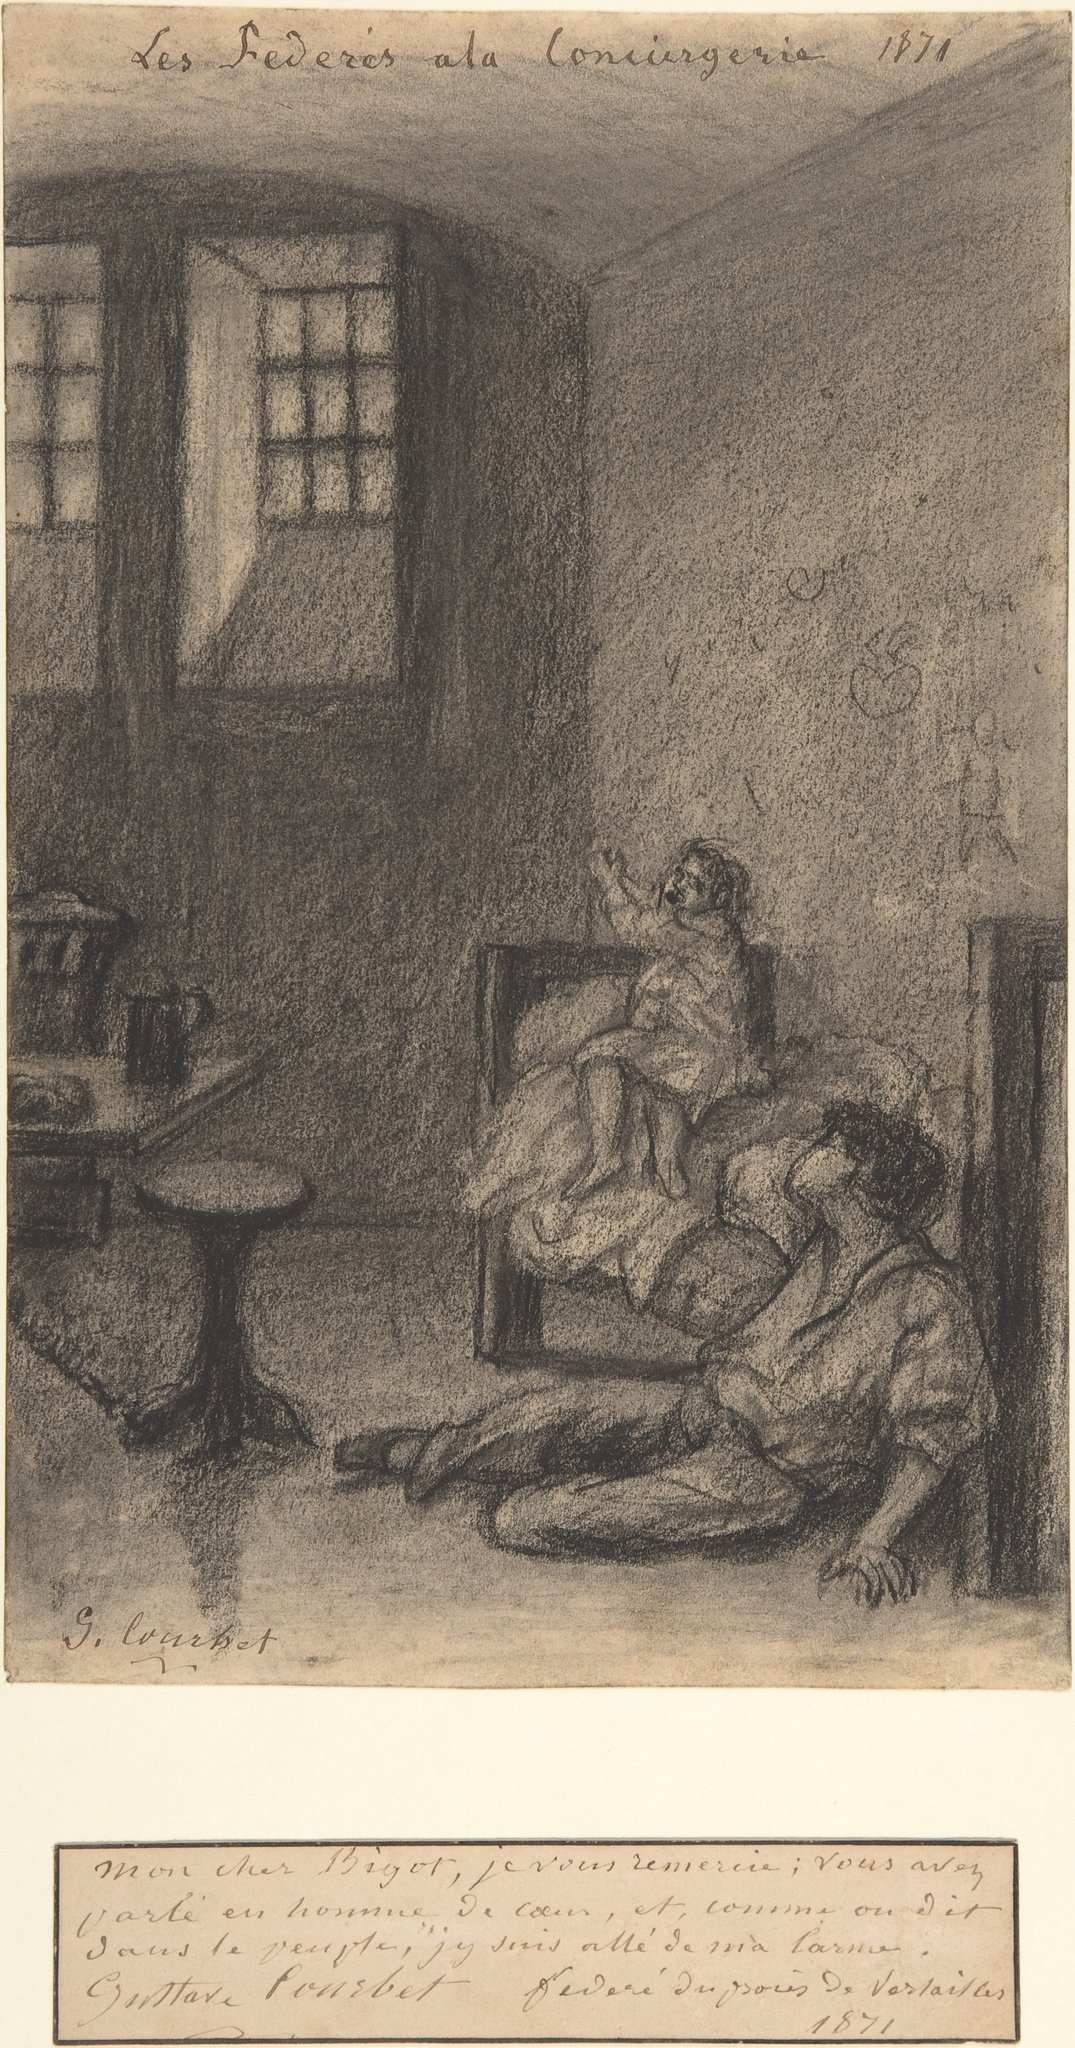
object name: drawing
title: Young Communards in Prison (Les Fédérés à la Conciergerie)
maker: gustave courbet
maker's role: artist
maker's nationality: french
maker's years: 1819-1877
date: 1871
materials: chalk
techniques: stumping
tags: prisons,prisoners,men